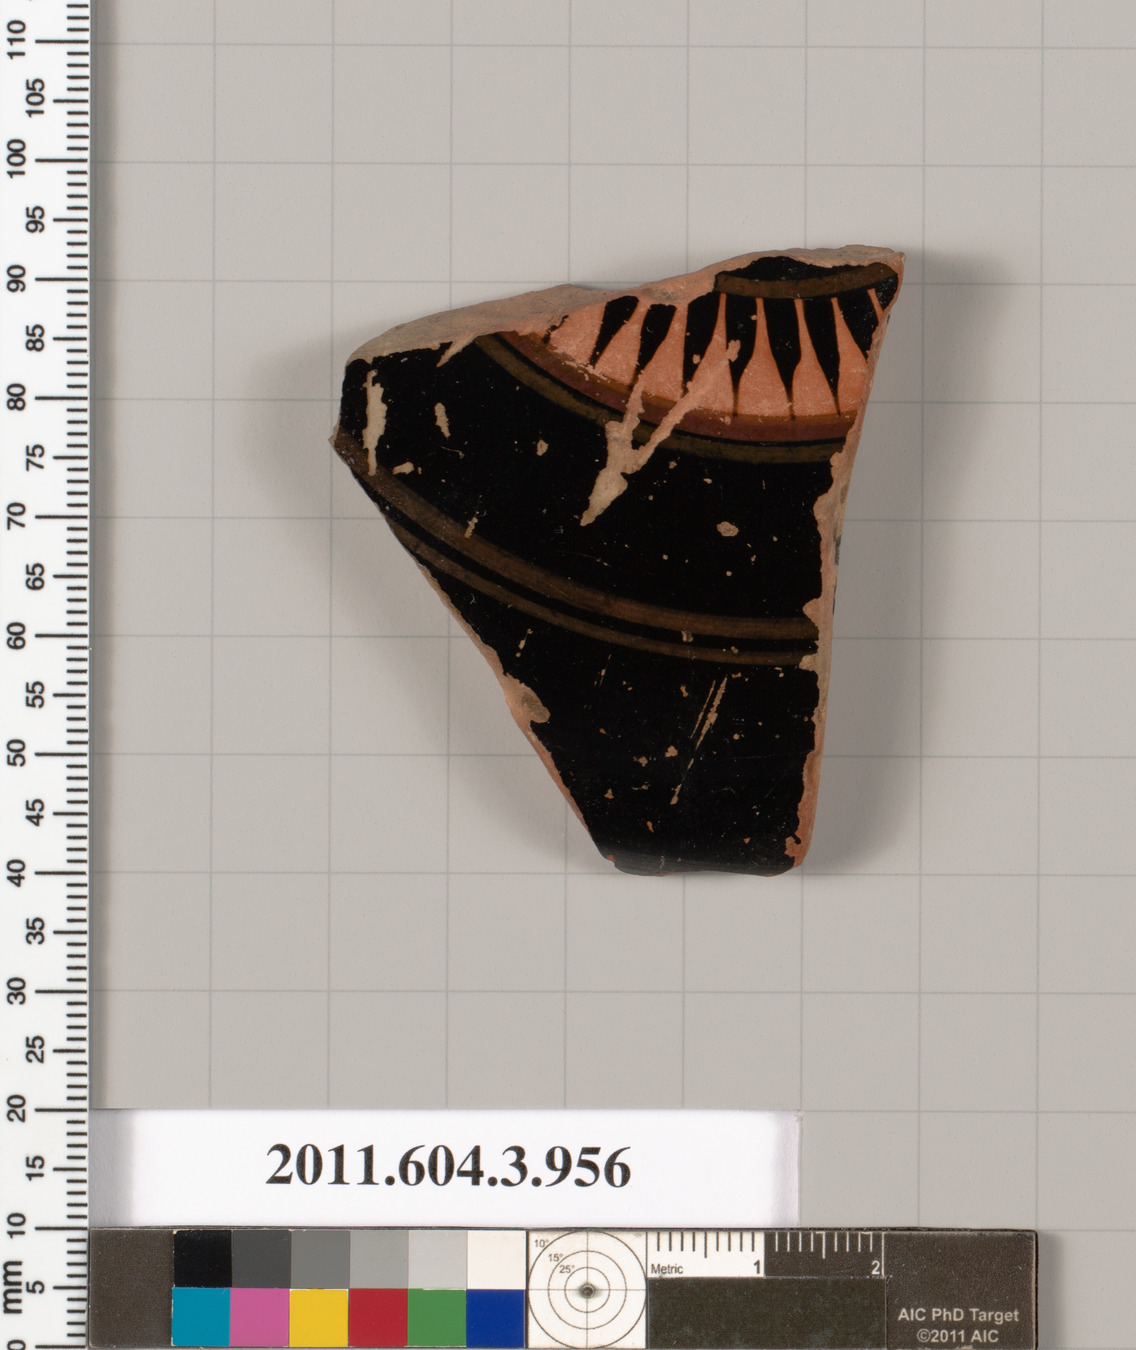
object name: lekanis lid fragment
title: Terracotta fragment of a lekanis lid (covered dish)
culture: greek, attic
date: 600-501 BCE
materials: terracotta